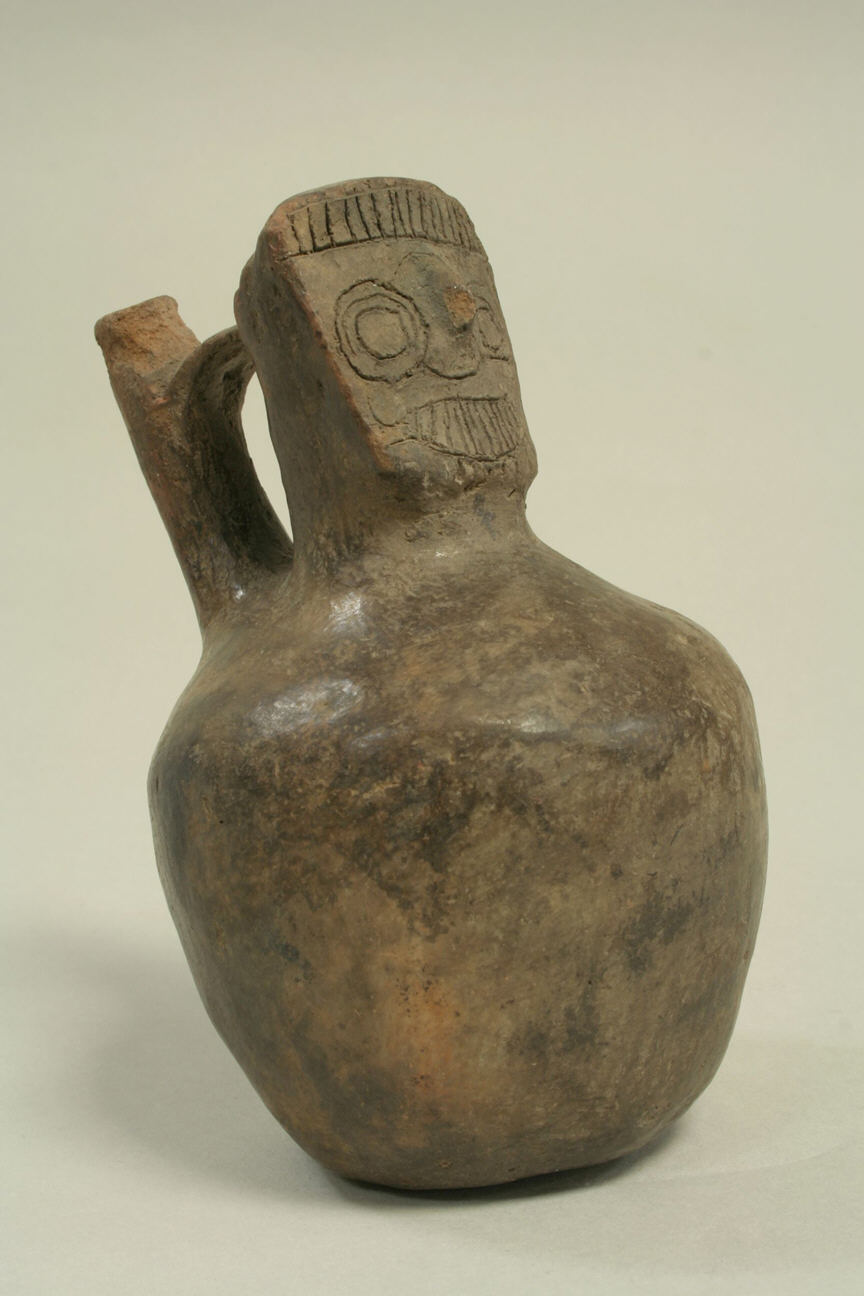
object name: bottle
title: Bridge and Spout Bottle with Head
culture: paracas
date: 700-301 BCE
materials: ceramic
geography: peru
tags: heads